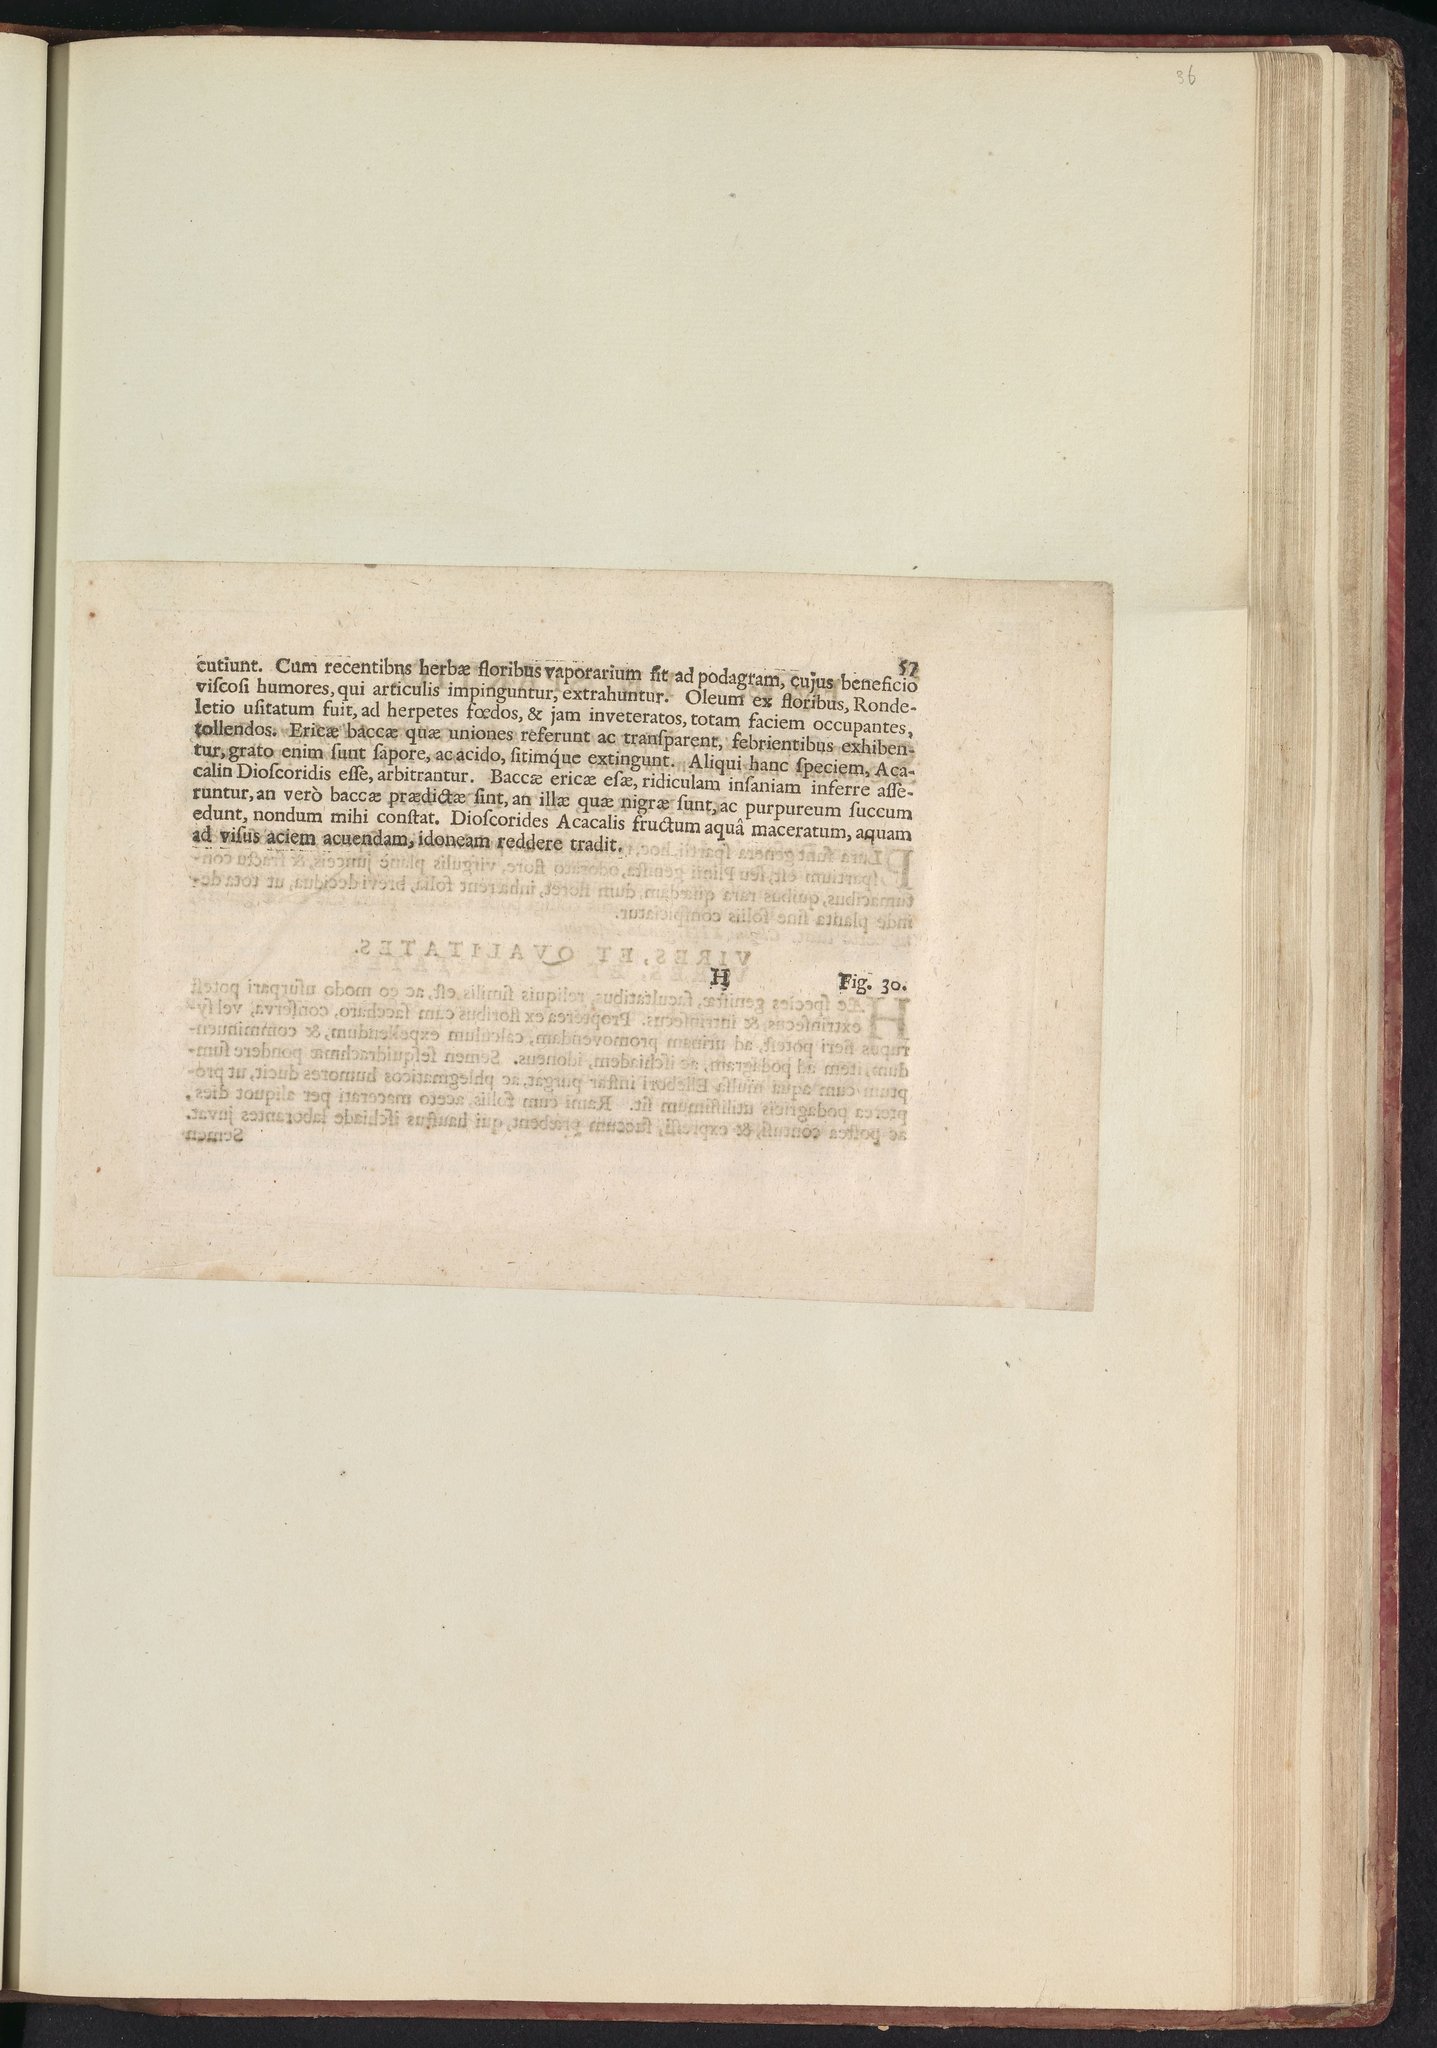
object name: text sheet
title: Fig. 29 'De Erica' in De Boodts herbarium van 1640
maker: anselmus boëtius de boodt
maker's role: draughtsman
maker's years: 1550-1632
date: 1640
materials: ink, paper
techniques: letterpress printing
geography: bruges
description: Beschrijving bij Fig. 29 op p. 57 in: Anselmi Boëtii de Boot I.C. Brugensis & Rodolphi II. Imp. Roman. medici a cubiculis Florum, Herbarum, ac fructuum selectiorum icones, & vires pleraeque hactenus ignotæ. Onderdeel van het album met bladen en platen uit De Boodts herbarium van 1640. Het twaalfde van twaalf albums met aquarellen van dieren, vogels en planten bekend rond 1600, gemaakt in opdracht van keizer Rudolf II.